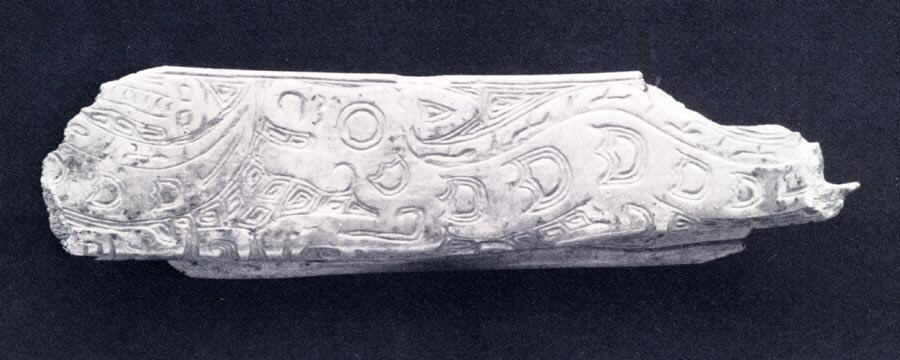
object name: carved bone fragment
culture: chinese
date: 1300-1001 BCE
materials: bone